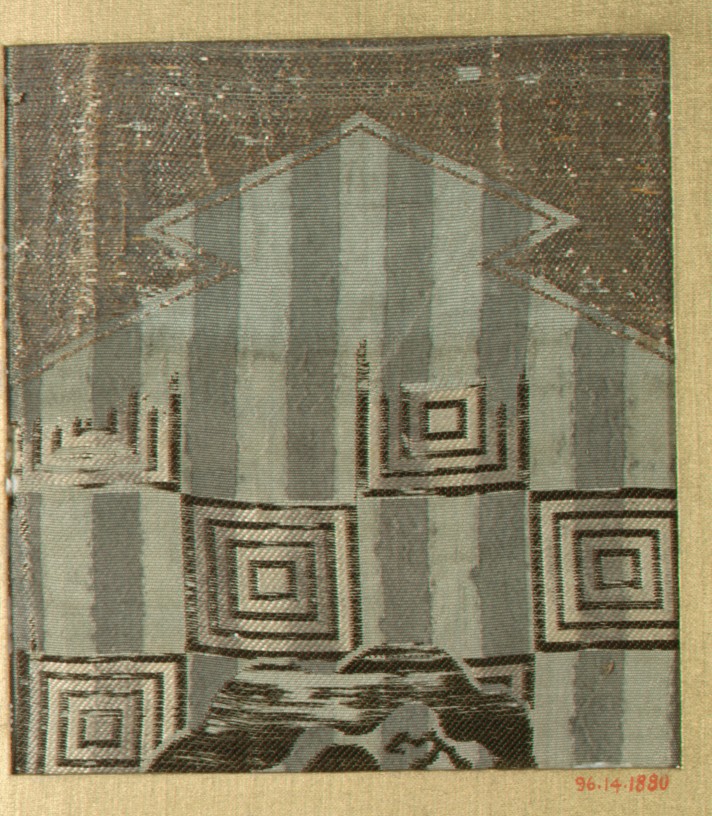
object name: piece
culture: japanese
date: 1701-1900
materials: silk